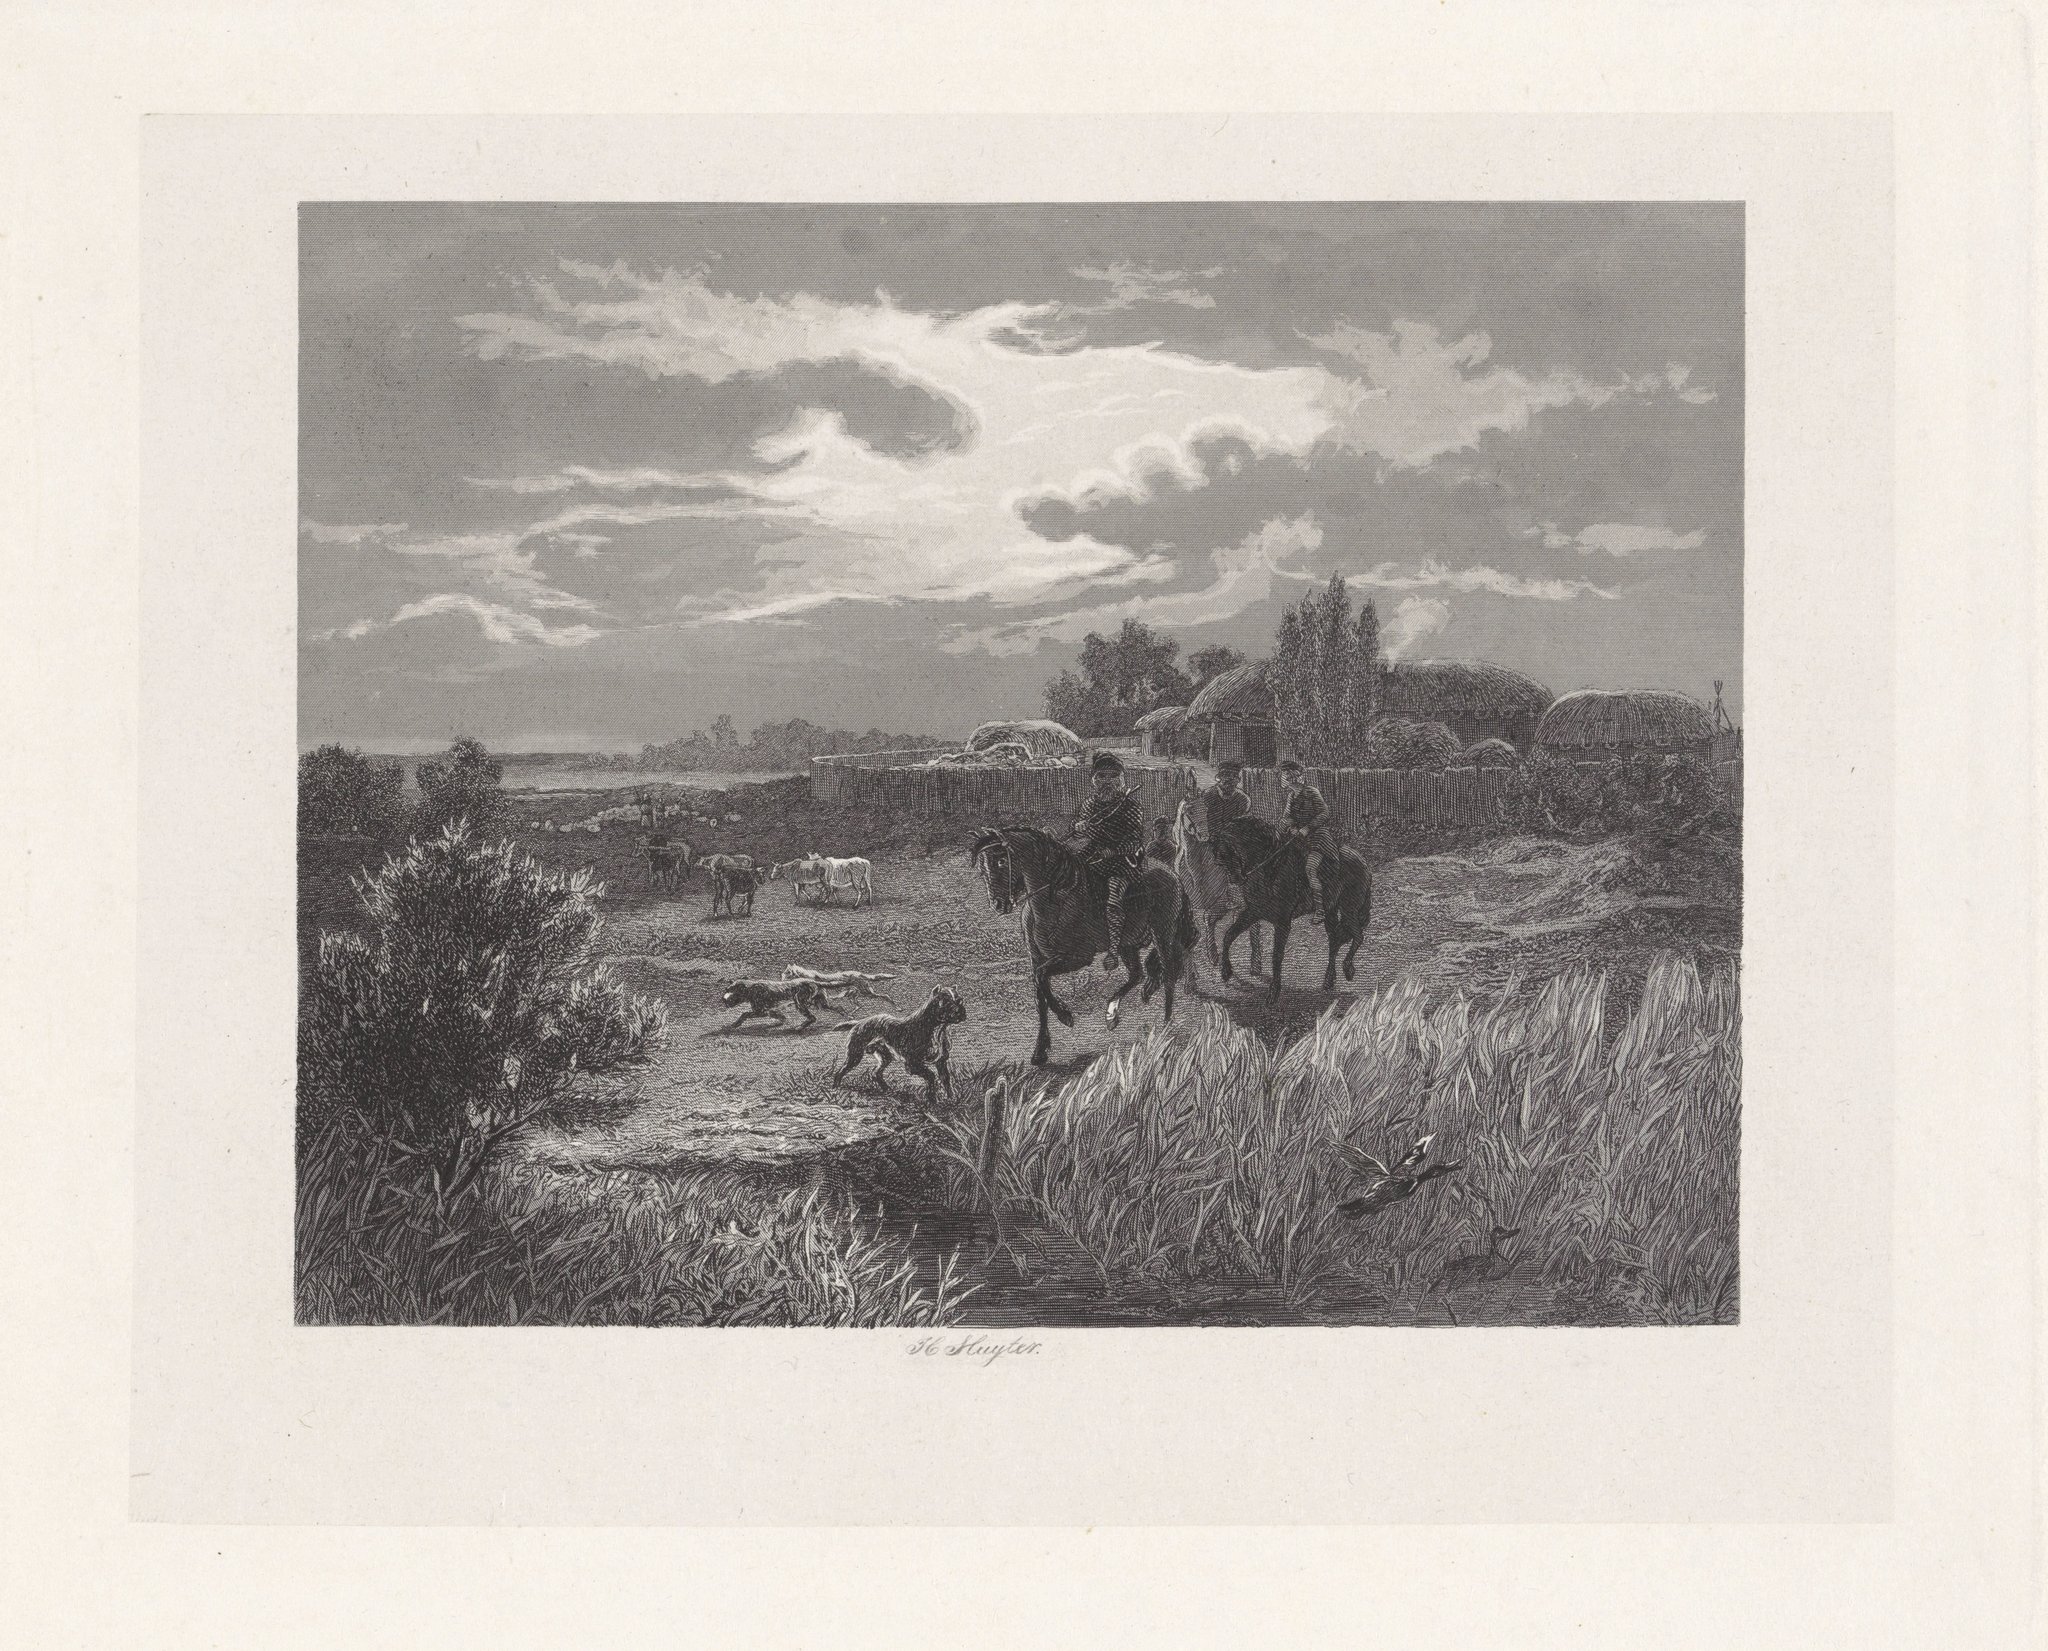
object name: history print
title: Saksische landhoeve in de 5e eeuw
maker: hendrik d. jzn sluyter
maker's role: print maker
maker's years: 1839-1931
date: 1865-1870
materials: paper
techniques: engraving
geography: netherlands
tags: night, netherlands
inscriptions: collector's mark: Lugt 2228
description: Illustratie voor: J. van Lennep en W. Moll en J. ter Gouw. Nederlands geschiedenis en volksleven in schetsen. Leiden: A.W. Sijthoff, [ca. 1870]. Staalgravures naar de schilderijen van de Historische Galerij der Maatschappij Arti en Amicitiae.